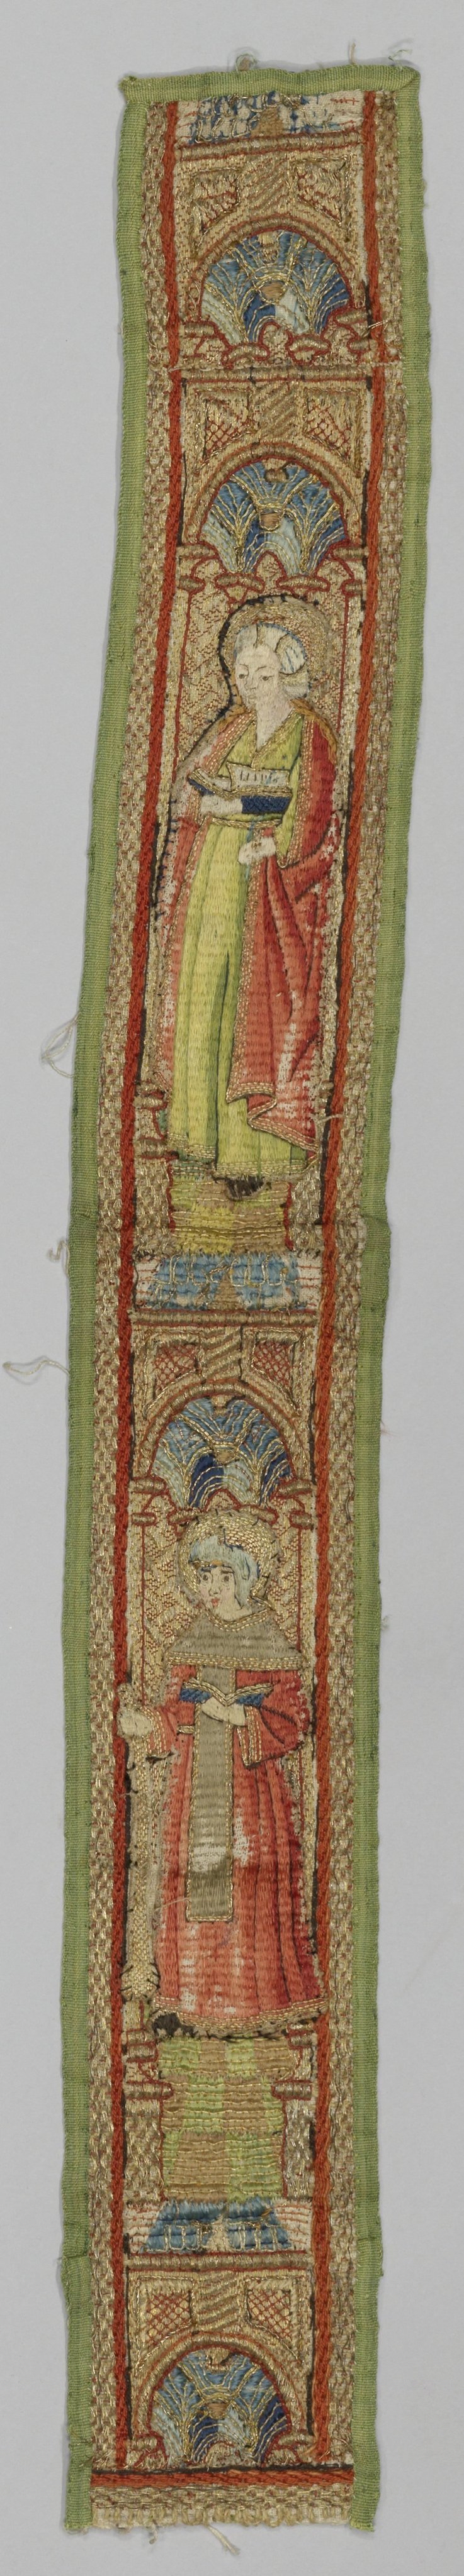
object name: fragment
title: Fragment van een dalmatiek, met borduurwerk van vlaszijde en gouddraad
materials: gold thread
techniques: embroidered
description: Fragment van een dalmatiek, met borduurwerk. Het borduurwerk heeft een afbeelding van twee heiligen (?). Het fragment hoort bij zes fragmenten met invnrs. BK-NM-9403-A t/m BK-NM-9403-E-B.